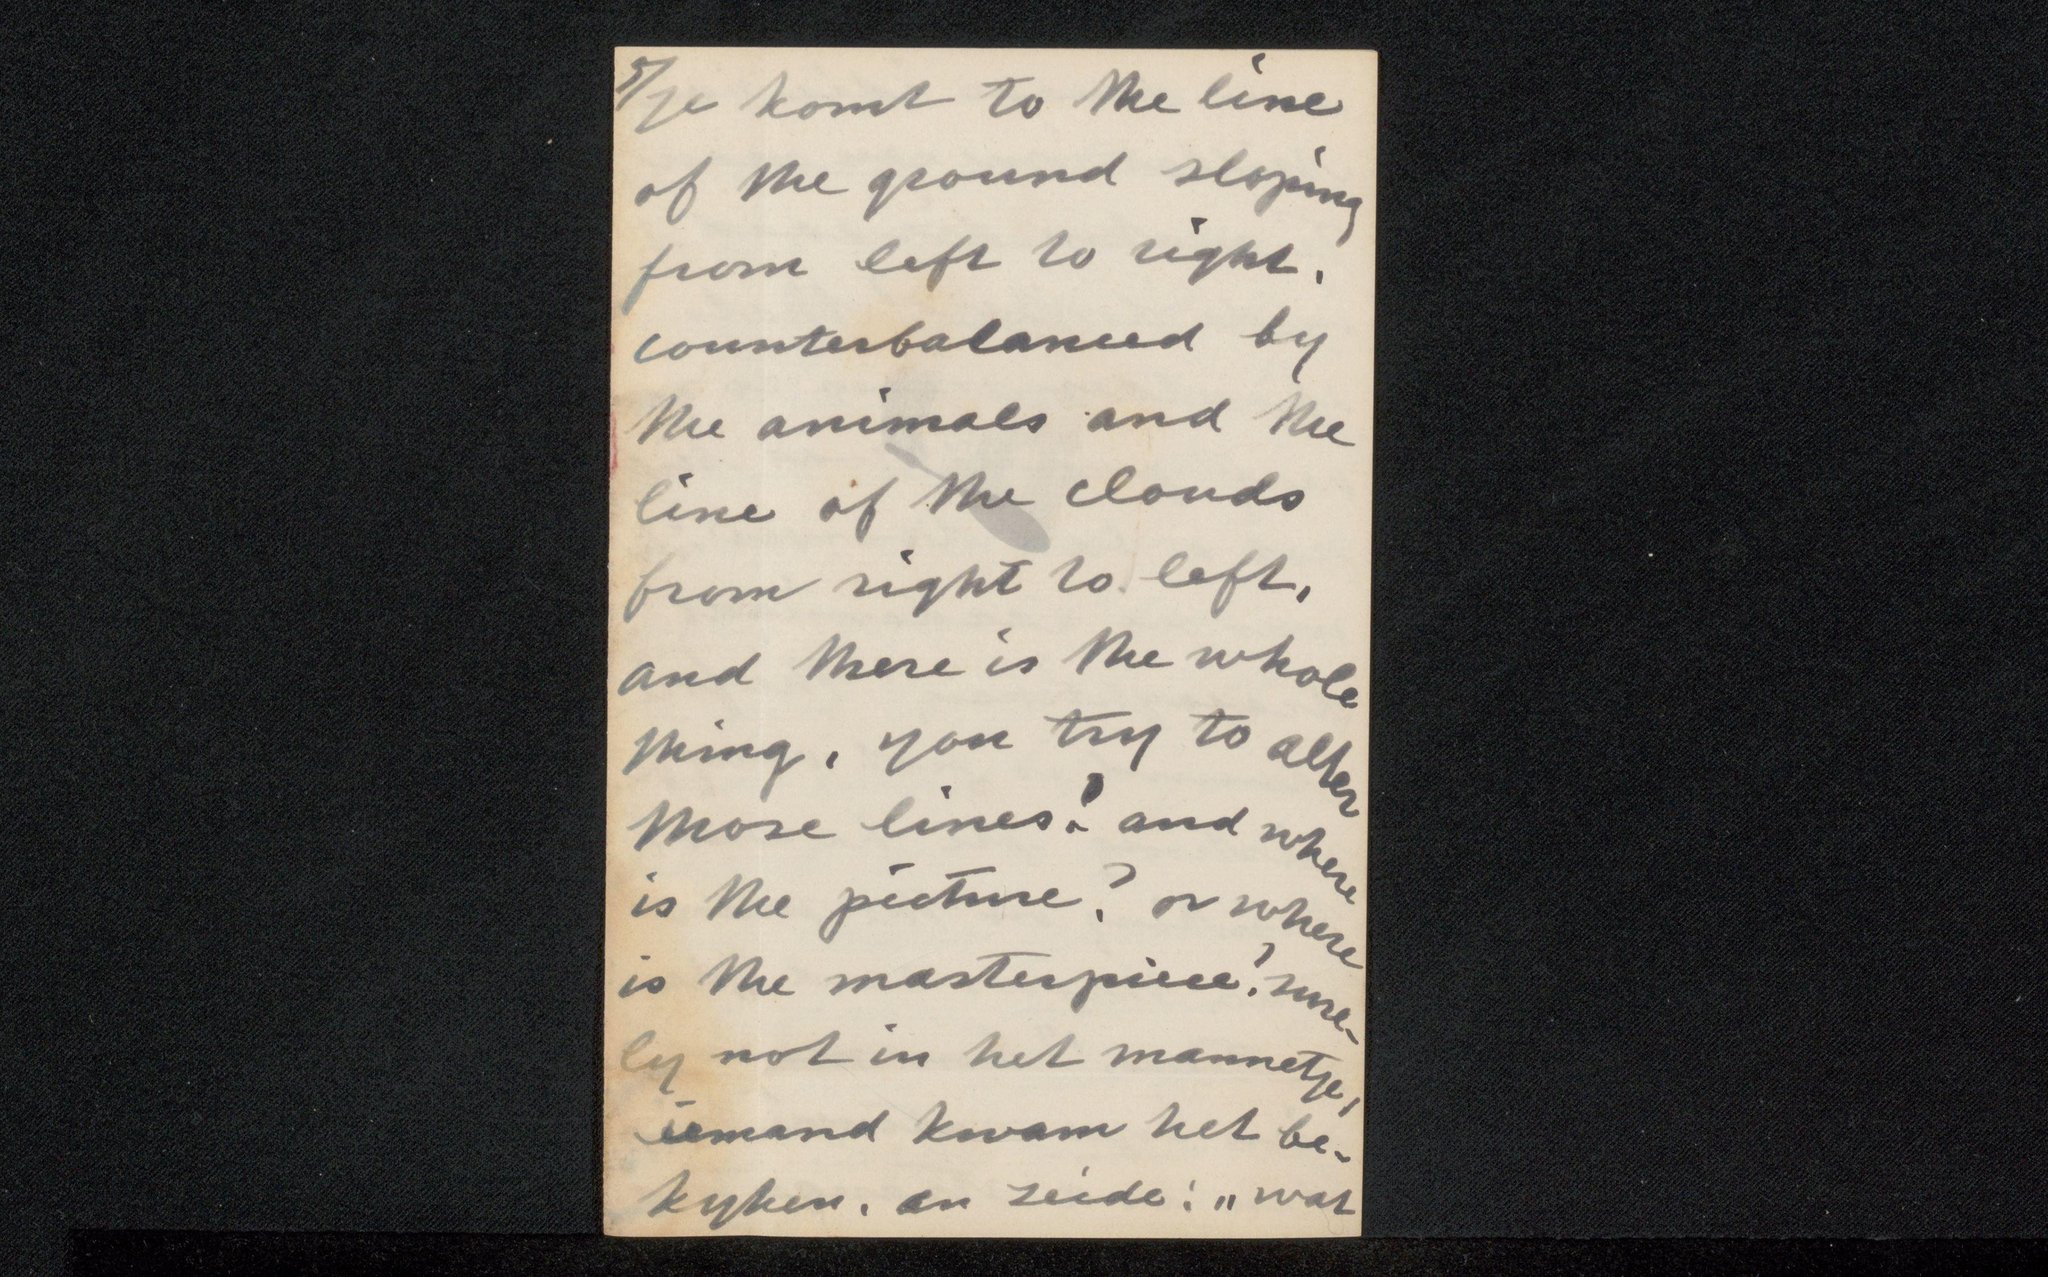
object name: letter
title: Brief aan Philip Zilcken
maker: matthijs maris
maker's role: draughtsman, painter, print maker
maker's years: 1839-1917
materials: ink, paper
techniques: pen, writing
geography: london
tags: print maker, draughtsman, lourens alma tadema, paris, camille corot, painter, jean françois millet, philip zilcken, criticizing and discussing art, art criticism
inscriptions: watermark, collector's mark: ‘RPK’